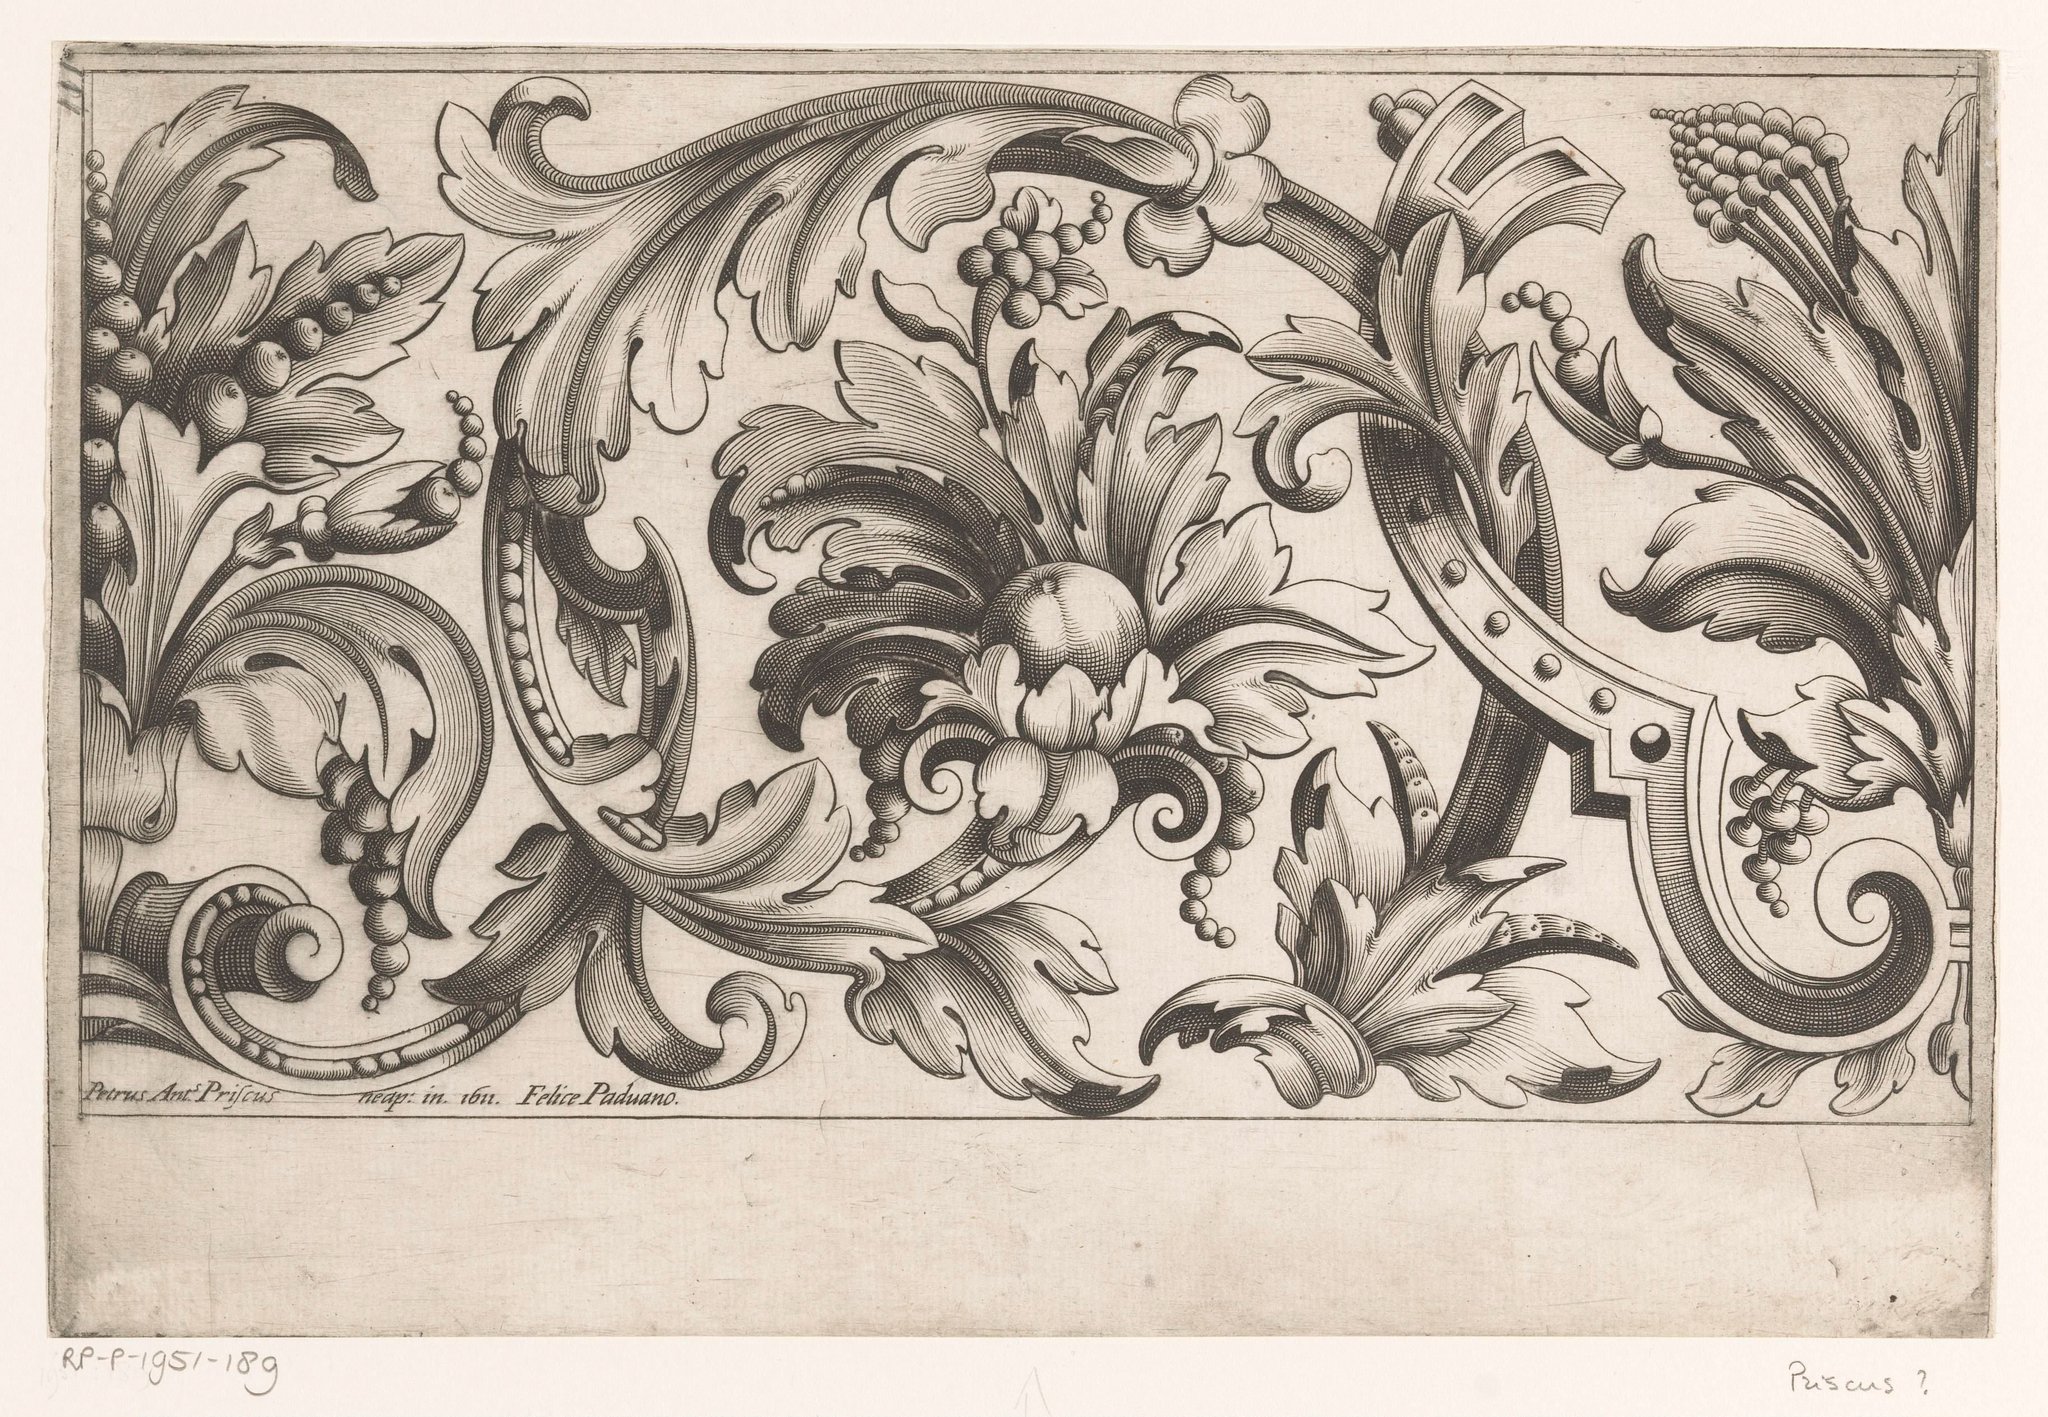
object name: print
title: Acanthusranken met rolwerkmotieven en vruchten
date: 1611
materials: paper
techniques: engraving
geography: italy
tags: acanthus ~ ornament - aa - stylized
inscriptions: collector's mark: Lugt 2228